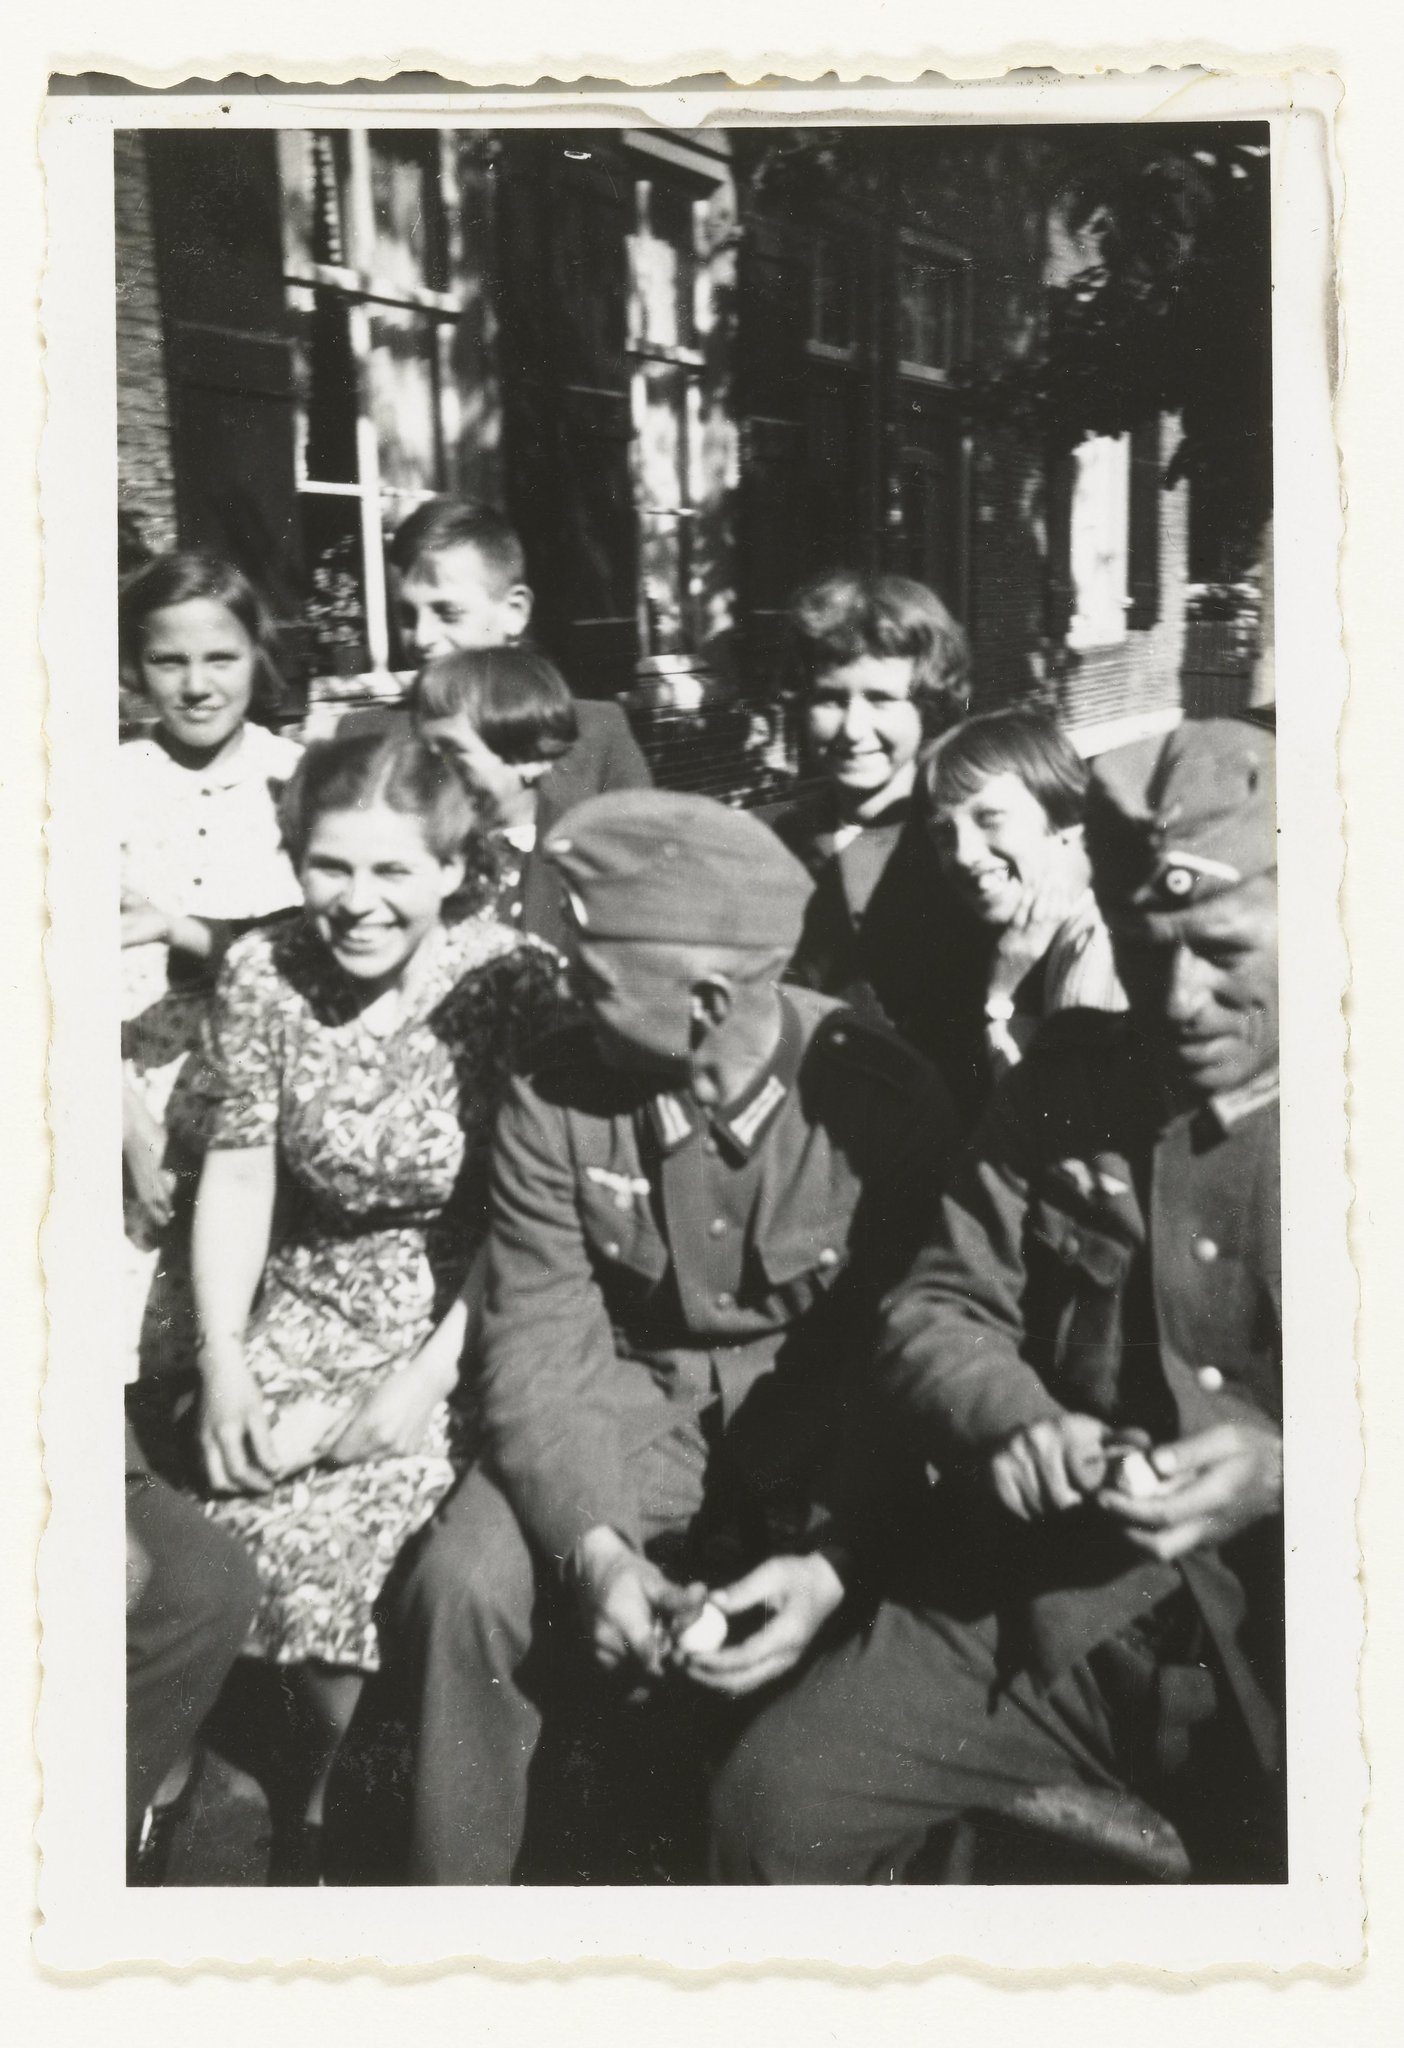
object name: photograph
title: Wehrmachtsoldaten schillen aardappelen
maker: Anonymous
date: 1909-1940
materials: photographic support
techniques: gelatin silver print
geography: raamsdonksveer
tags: occupier and civilians, occupation ~ war, cleaning vegetables - cc - in the open air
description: Twee Wehrmacht militairen helpen een Nederlandse familie met aardappelen schillen. Achter hen een paar kinderen. Achterop staat: Holland Sept. 1940. Adriane bei dem Kartoffel schälern auf einen Sonntag.